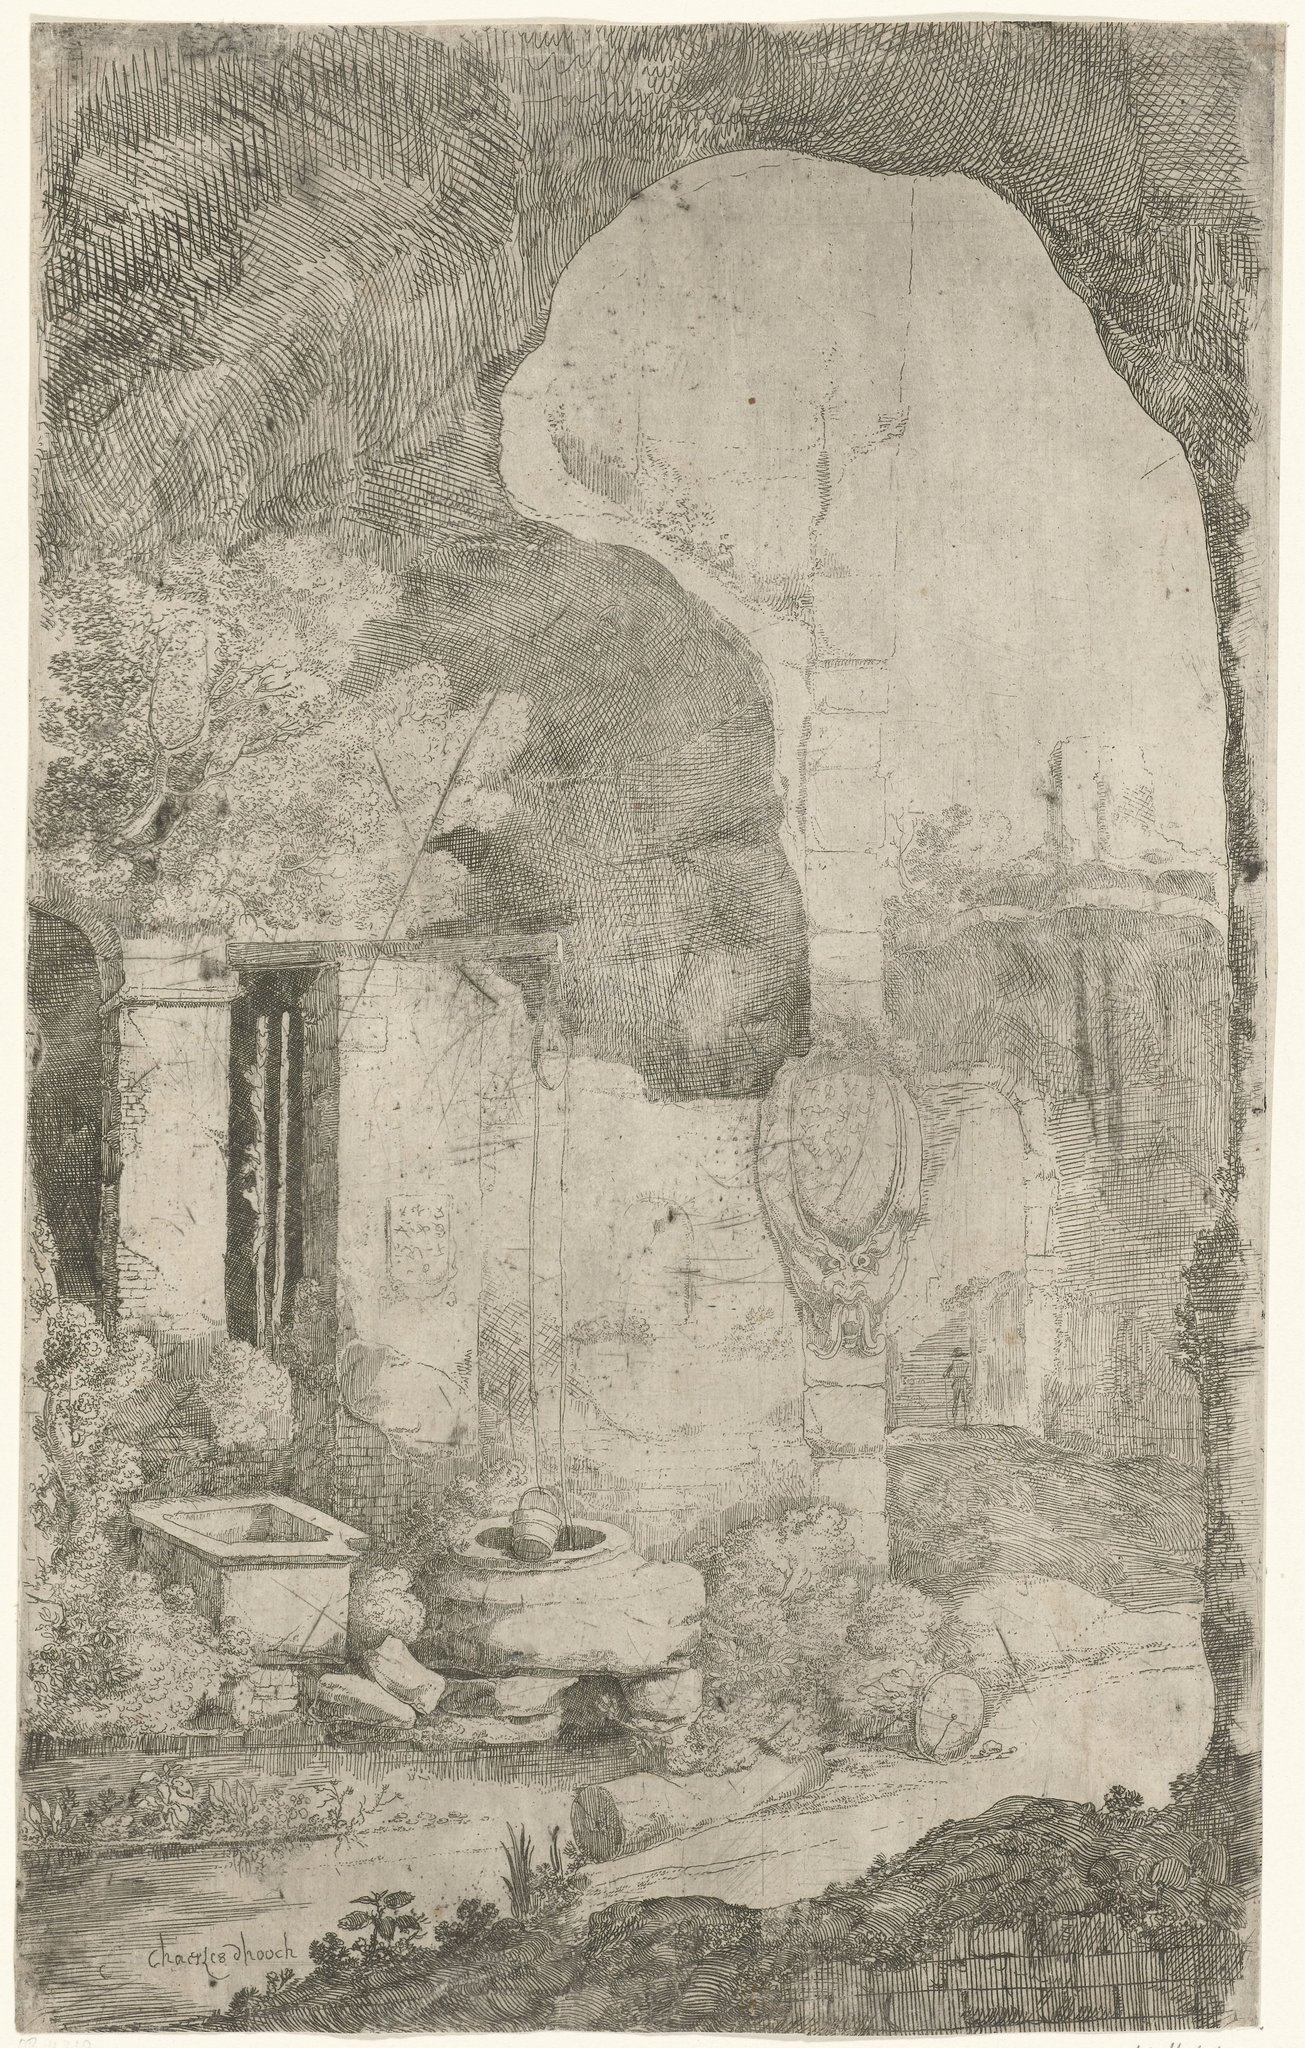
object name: print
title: Waterput bij een ruïne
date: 1613-1638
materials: paper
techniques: etching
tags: well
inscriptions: collector's mark: Lugt 2228, collector's mark: Lugt 240